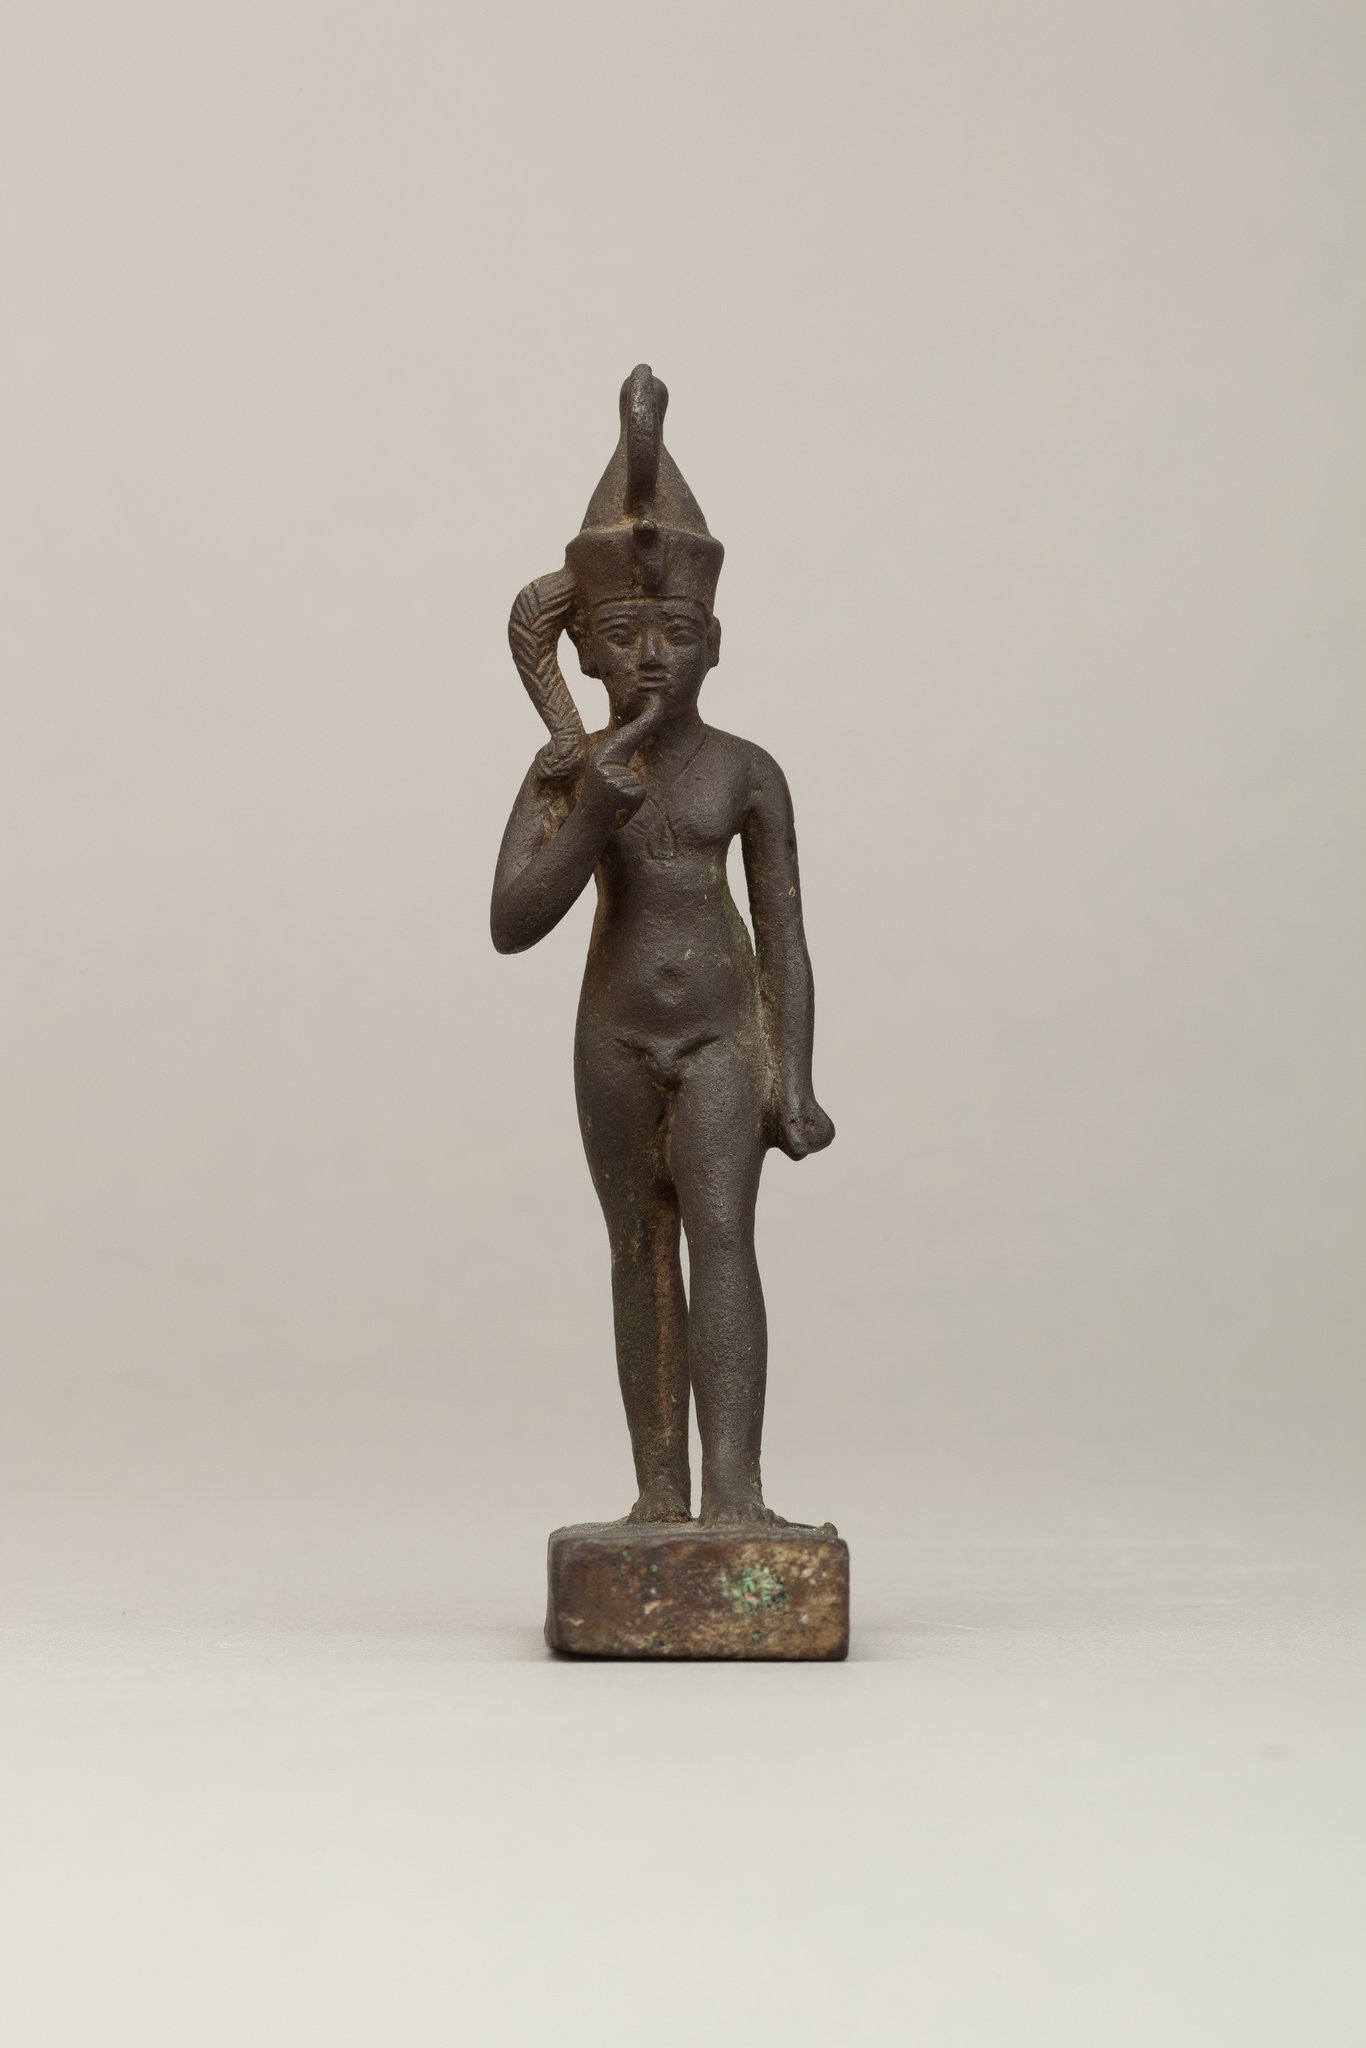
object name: statuette, harpokrates, double crown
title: Harpokrates in double crown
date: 664-630 BCE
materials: metal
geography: egypt